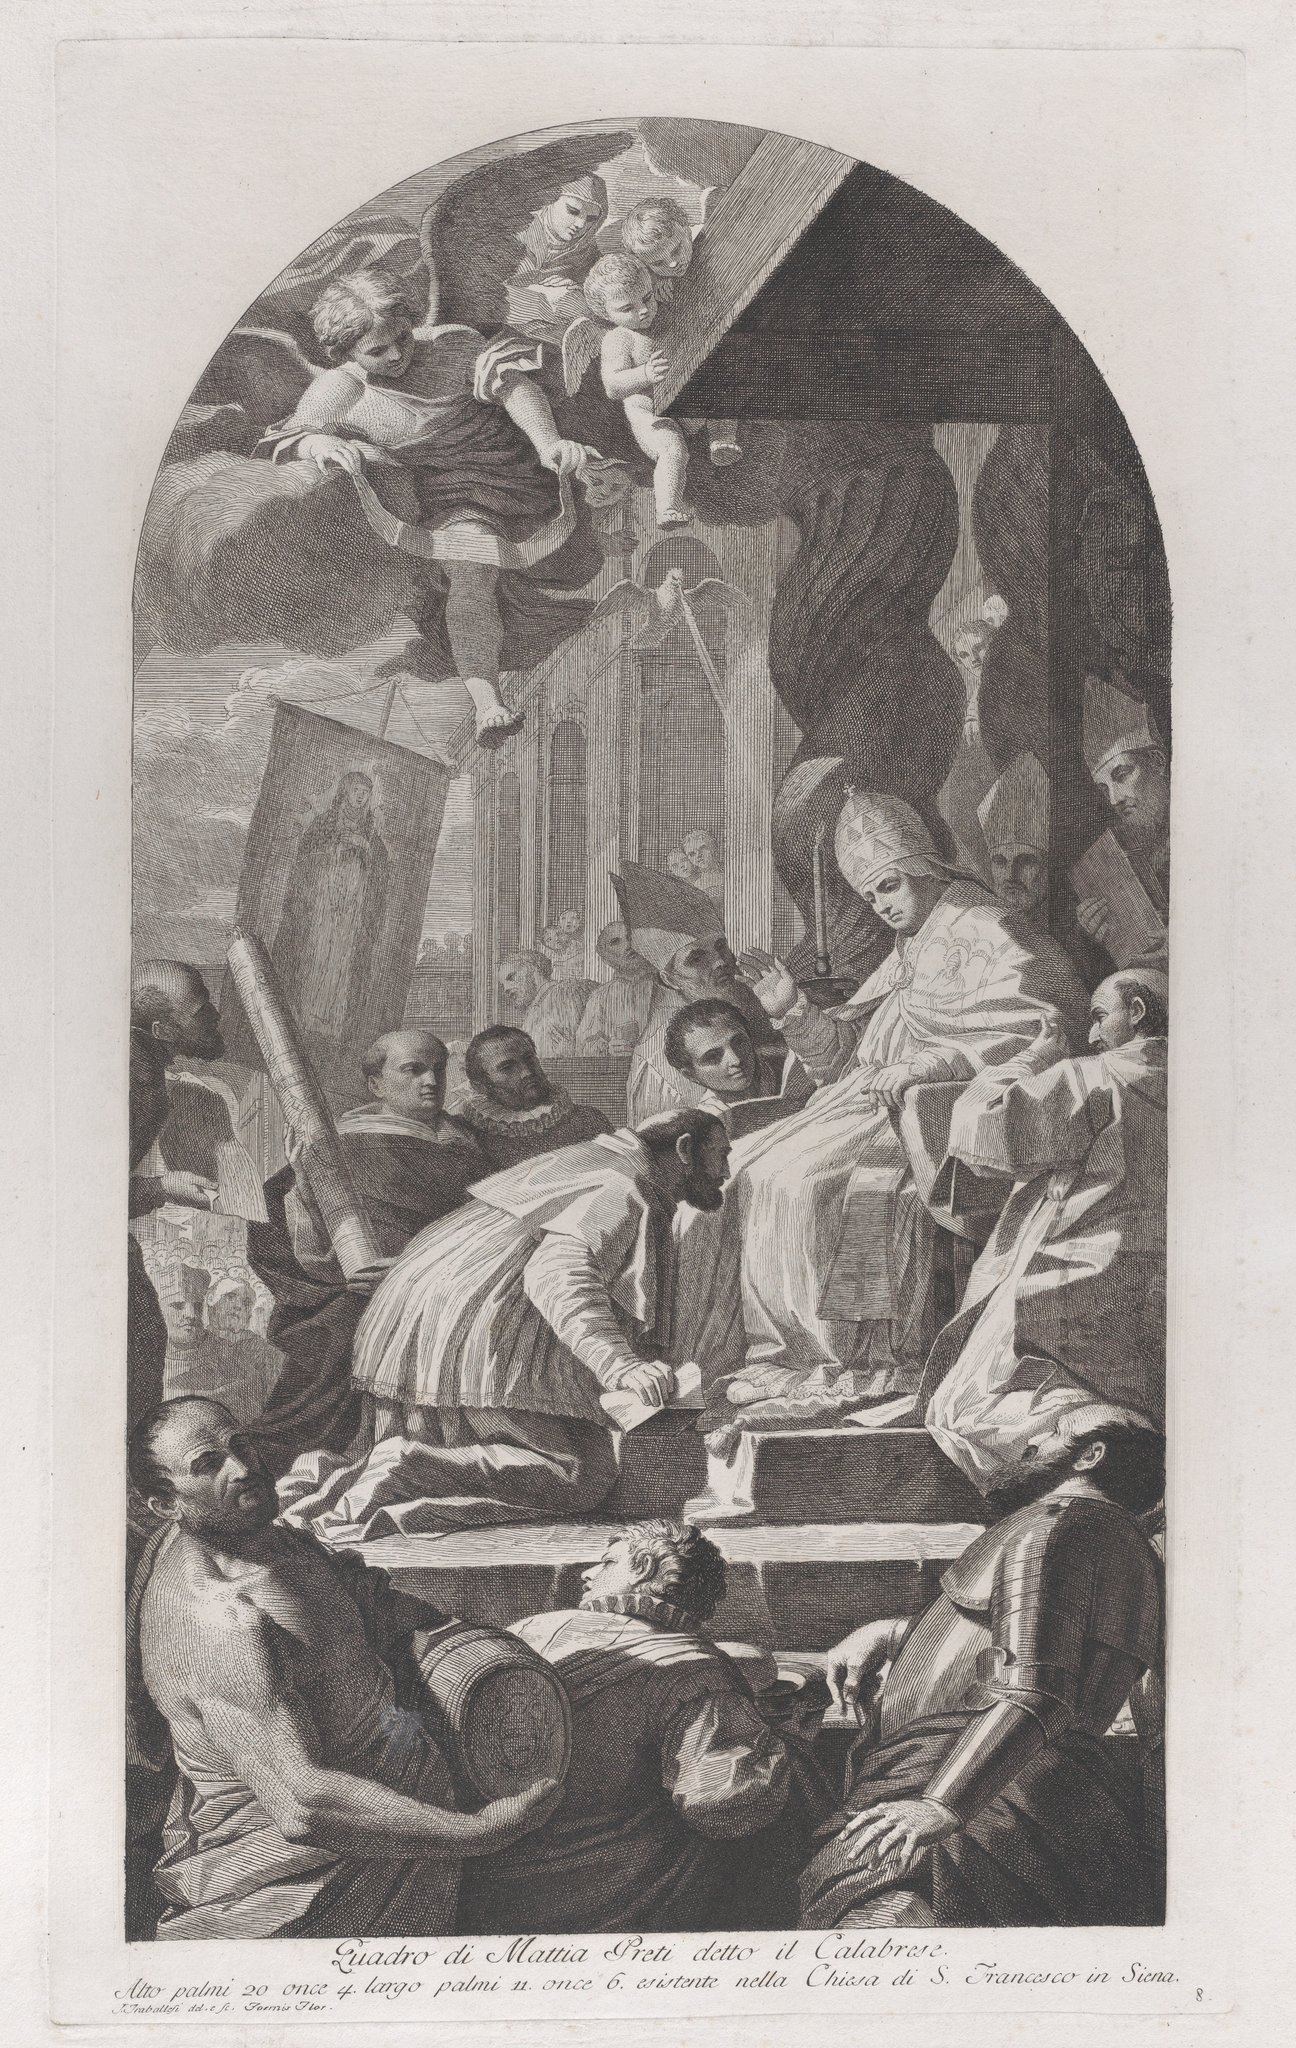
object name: print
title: Plate 8: Canonization of Saint Catherine of Siena; Pius II seated on a throne at right, blessing his nephew, Francesco Todeschini Piccolomini, who kneels before him; after Mattia Preti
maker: giuliano traballesi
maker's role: artist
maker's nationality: italian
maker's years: 1727-1812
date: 1760-1780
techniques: engraving, etching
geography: florence